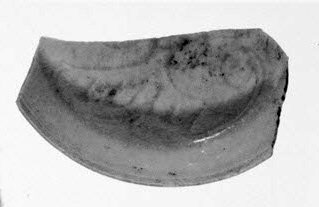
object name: fragment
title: Fragment of a Bowl (Study Collection)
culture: chinese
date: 960-1279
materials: porcelain